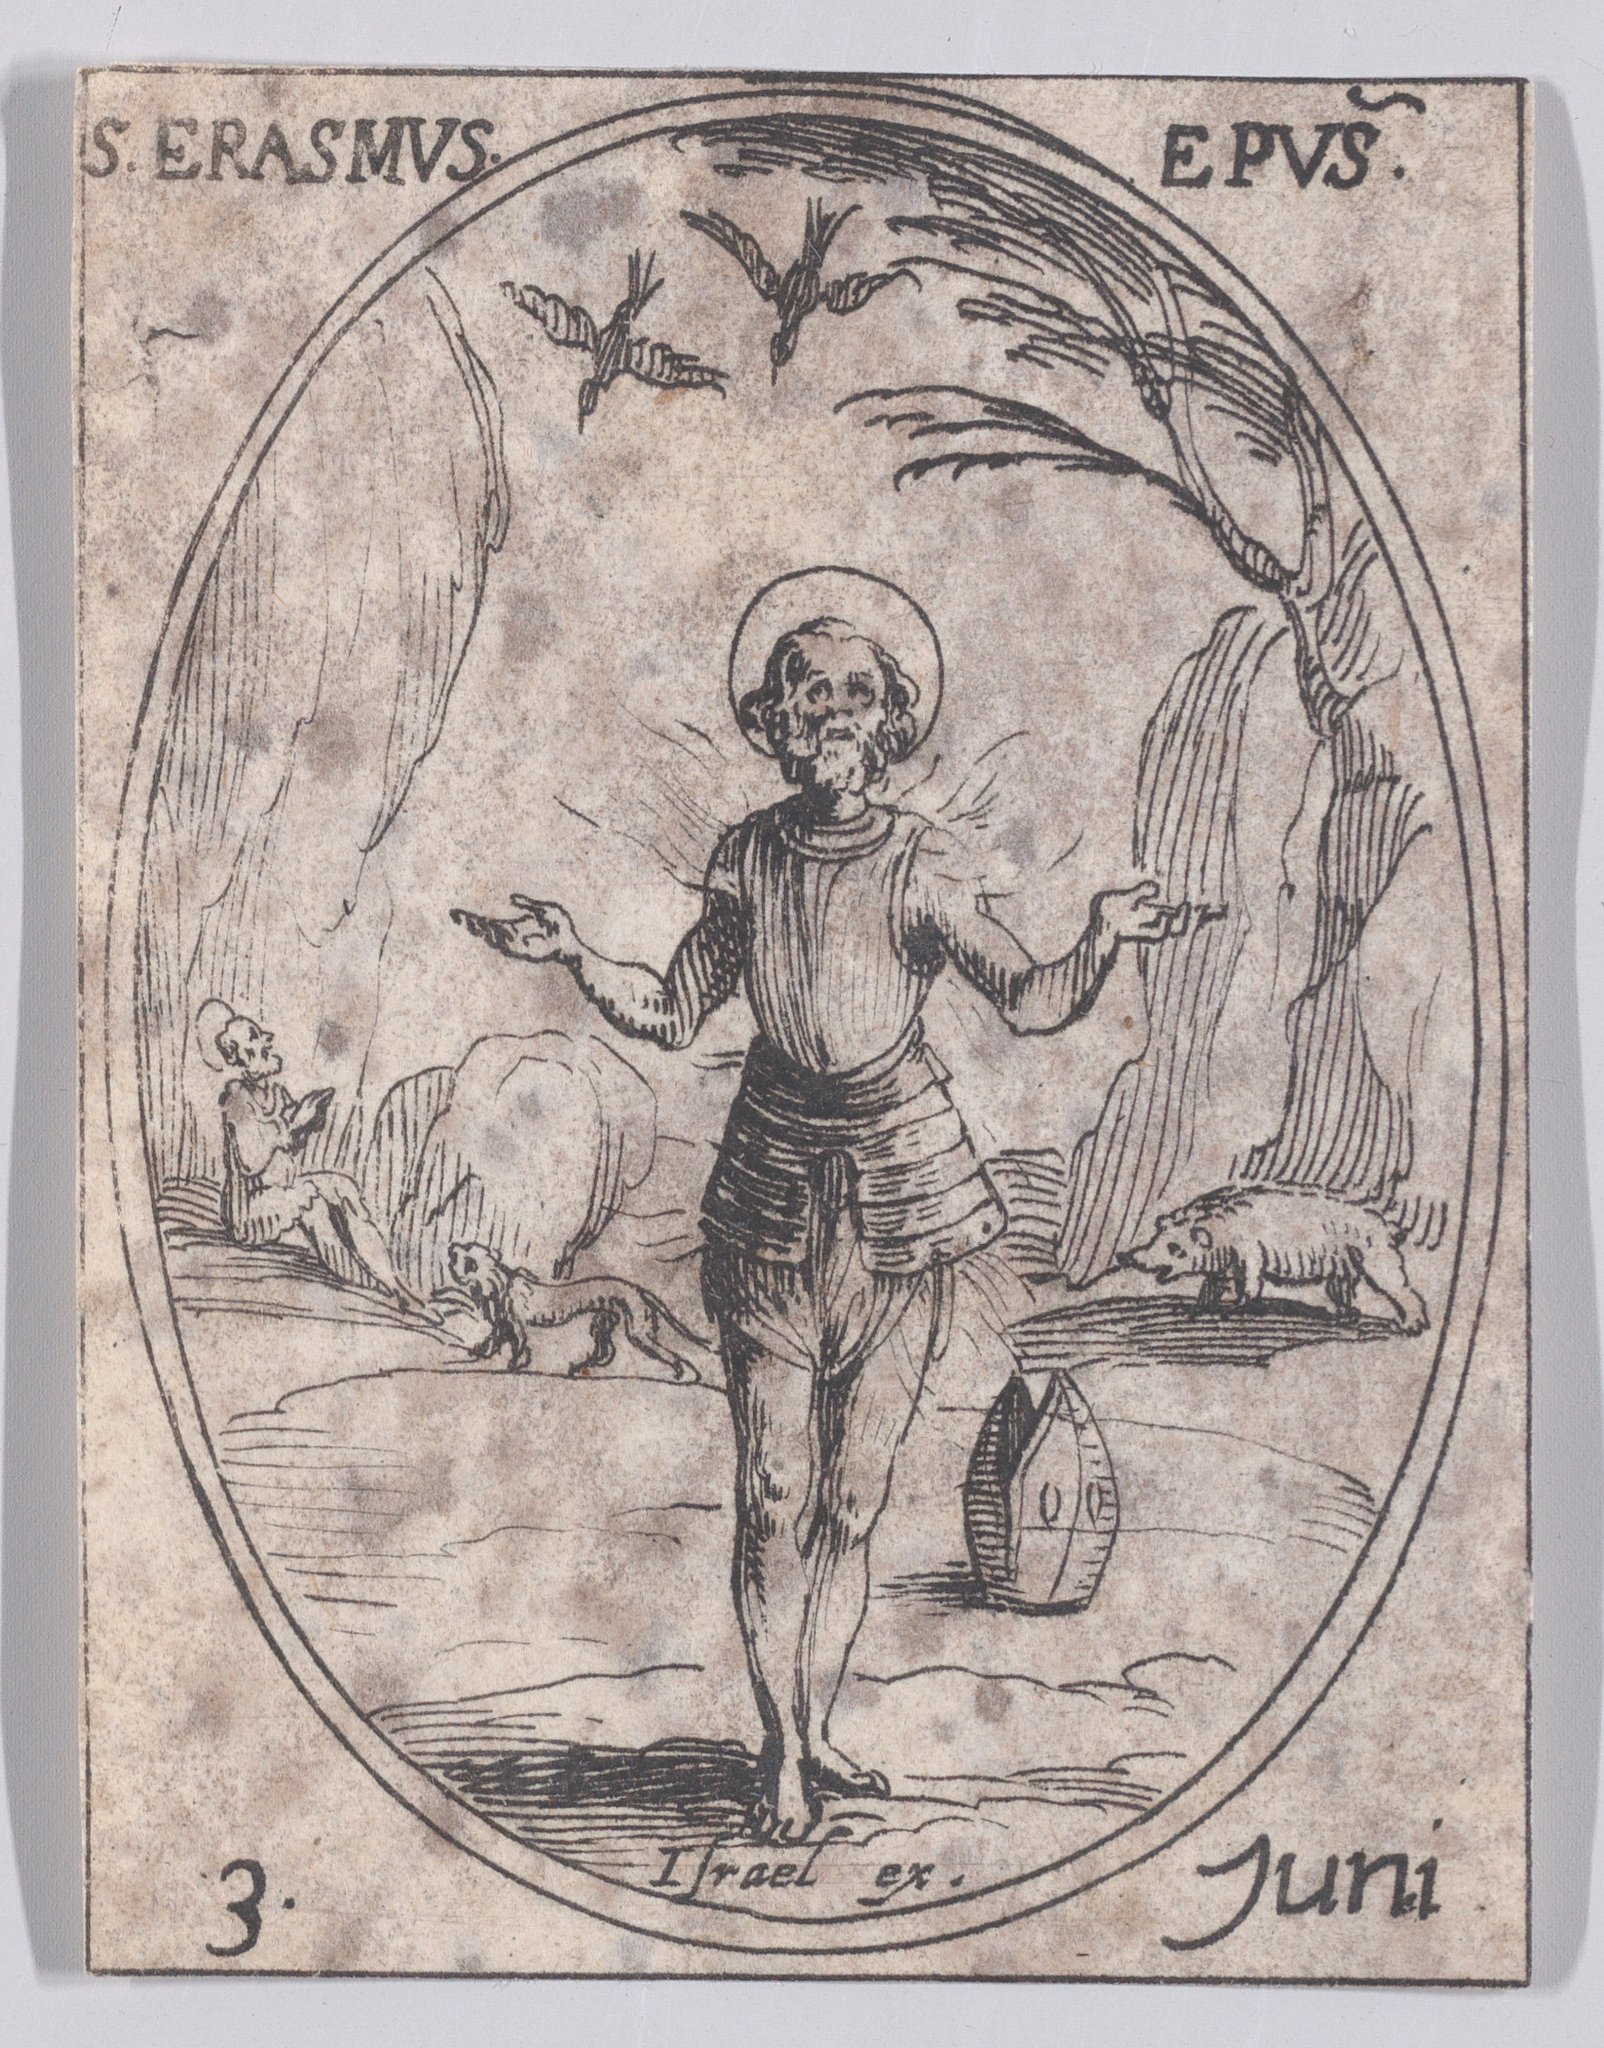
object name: print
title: S. Erasme, évêque (St. Erasmus, Bishop), June 3rd, from "Les Images De Tous Les Saincts et Saintes de L'Année" (Images of All of the Saints and Religious Events of the Year)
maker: jacques callot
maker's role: artist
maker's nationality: french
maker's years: 1592-1635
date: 1636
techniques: etching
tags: men,saints